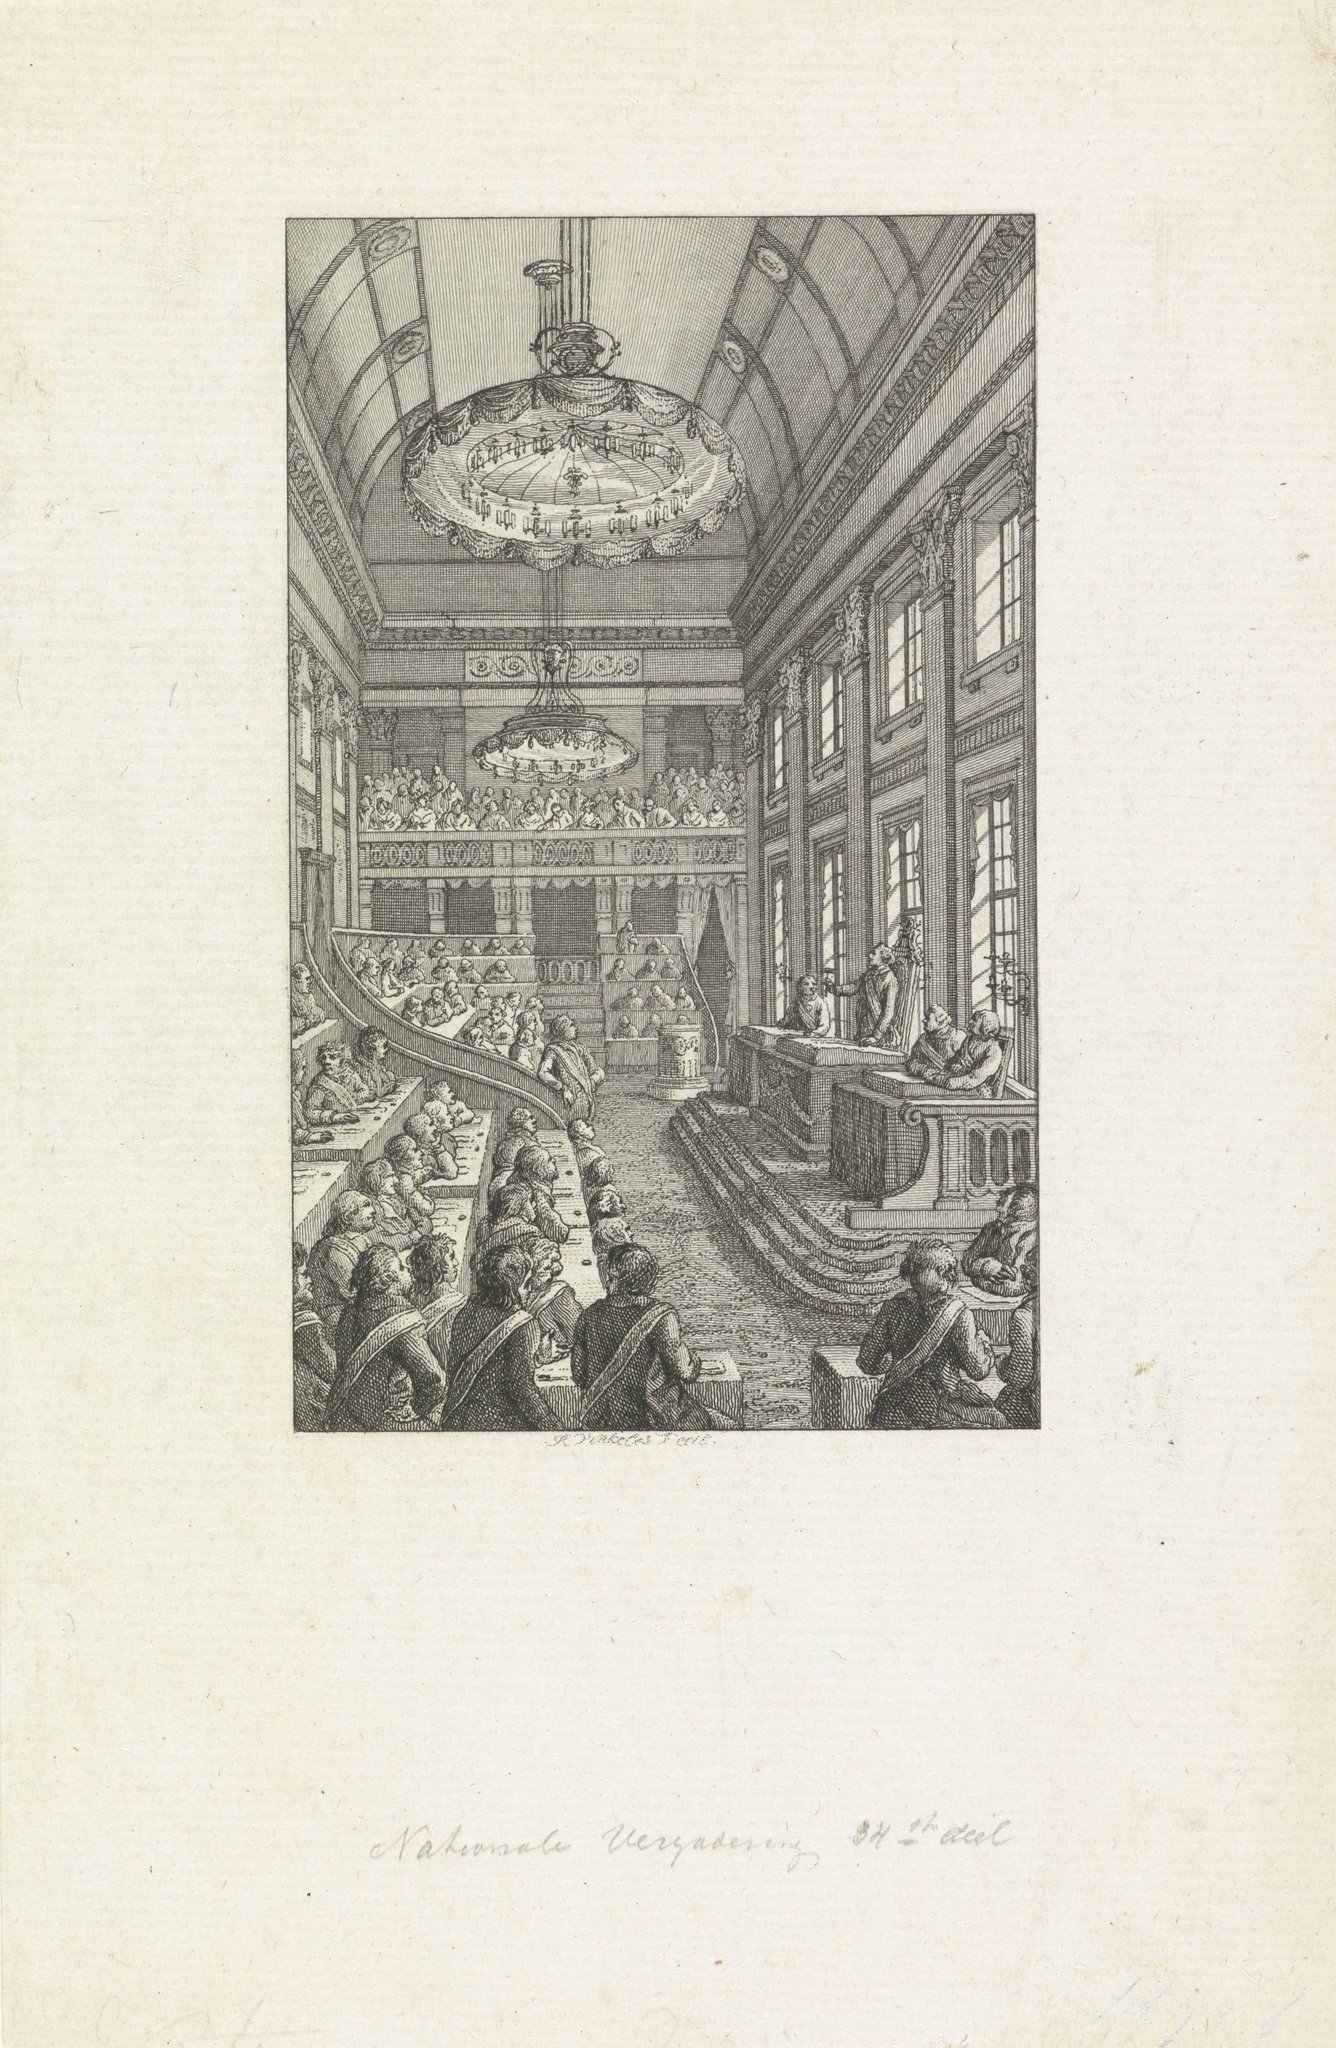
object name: print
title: Eerste Nationale Vergadering in Den Haag, 1796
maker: reinier vinkeles (i)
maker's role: draughtsman, print maker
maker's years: 1741-1816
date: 1803-1805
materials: paper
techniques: engraving, etching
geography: netherlands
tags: pieter paulus, revolutionary government, lower house, parliament, chamber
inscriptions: collector's mark: Lugt 2228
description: Zitting van de Eerste Nationale Vergadering in Den Haag, van 1 maart 1796 tot 31 augustus 1797. Gezicht in de vergaderzaal (voormalige danszaal van het Stadhouderlijke Paleis) met de leden, allen met lint als representant. Rechts spreek de voorzitter Pieter Paulus de leden toe en verklaart de Nationale Vergadering gevestigd. Op de achtergrond de volle publieke tribune.